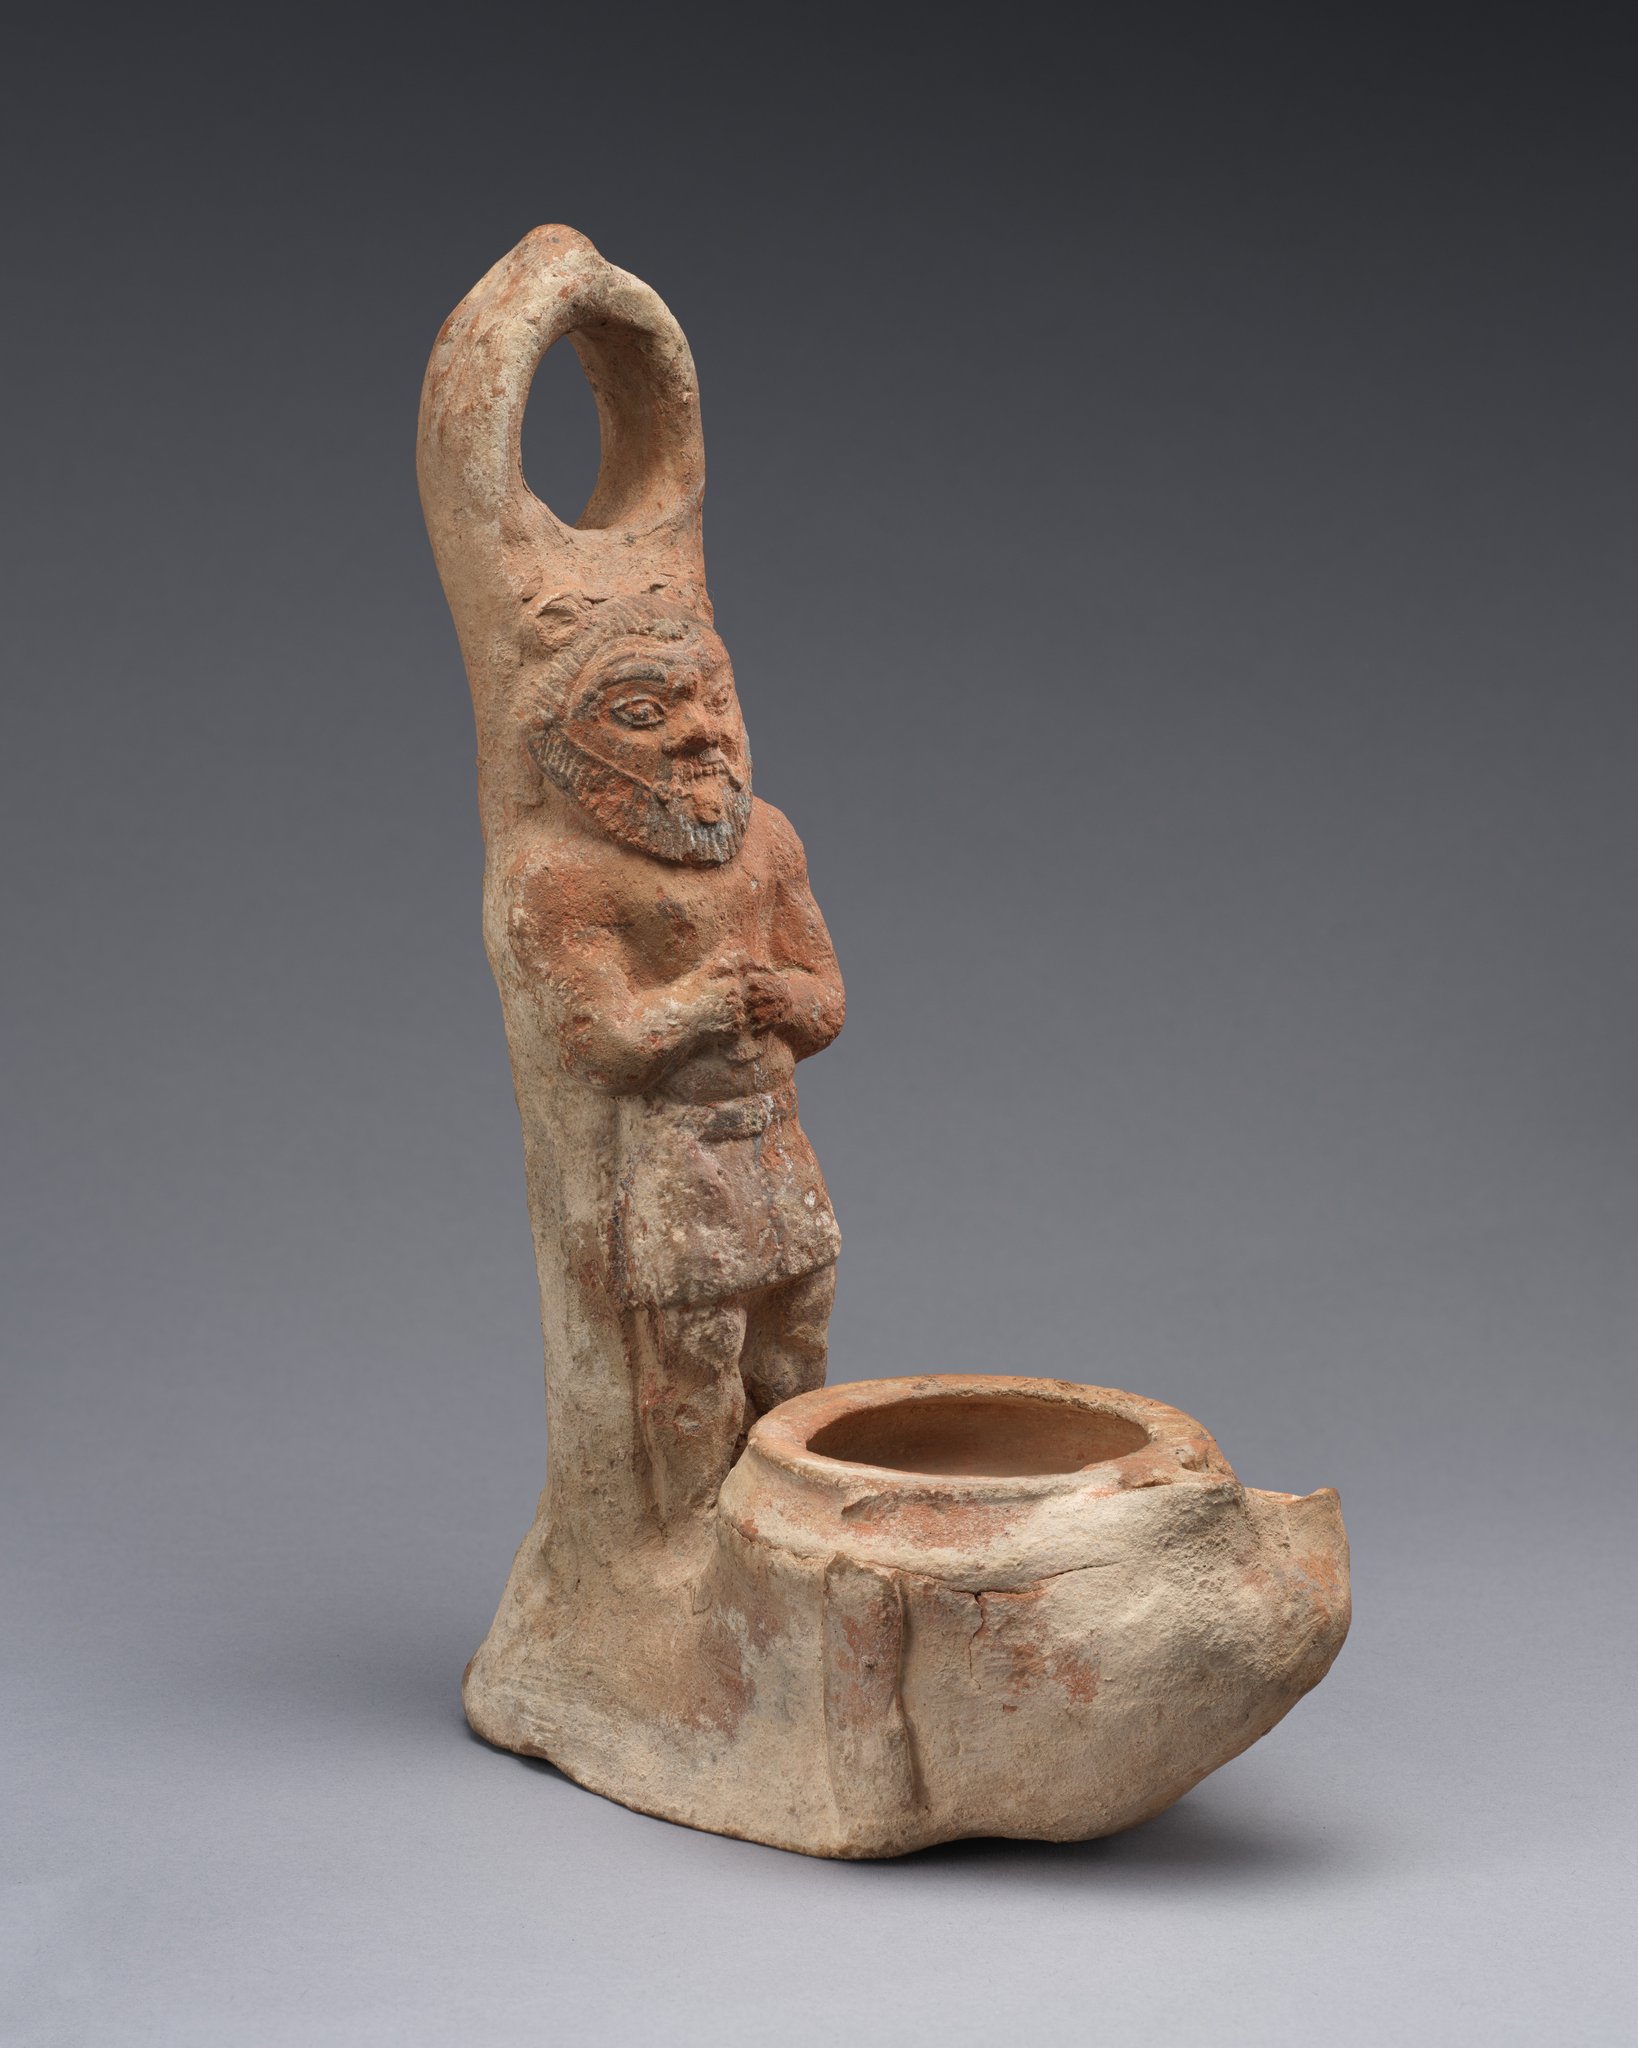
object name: lamp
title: Terracotta lamp representing Bes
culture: cypriot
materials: terracotta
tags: bes